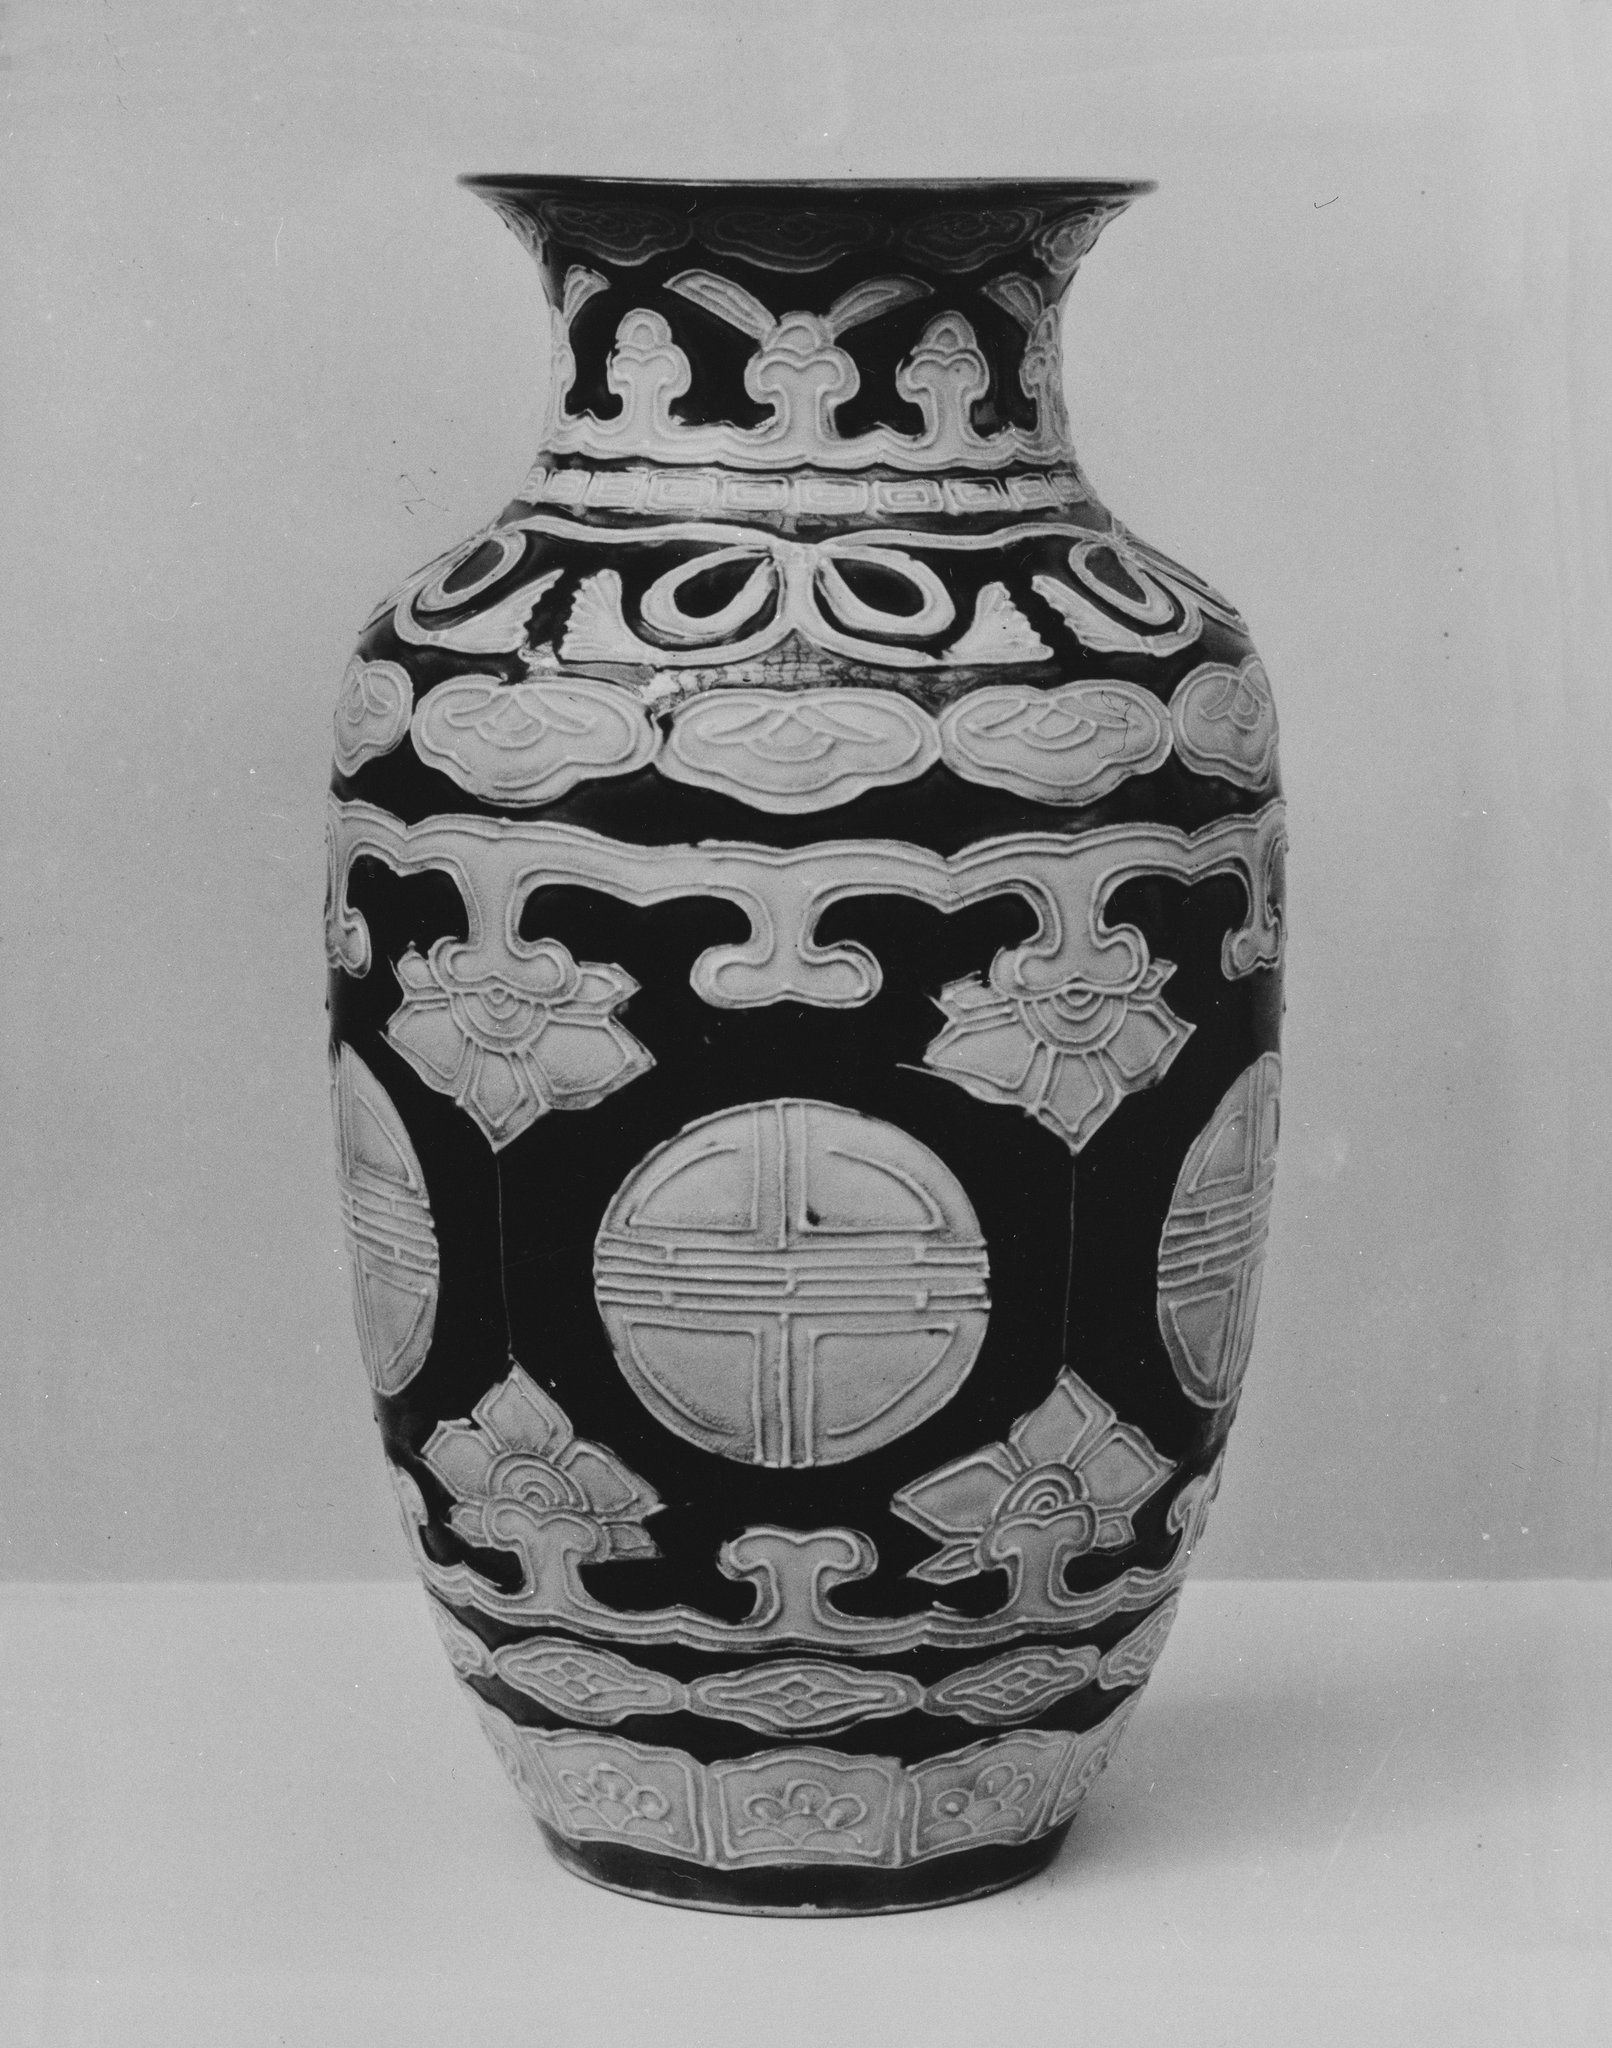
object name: vase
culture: japanese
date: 1820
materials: stoneware